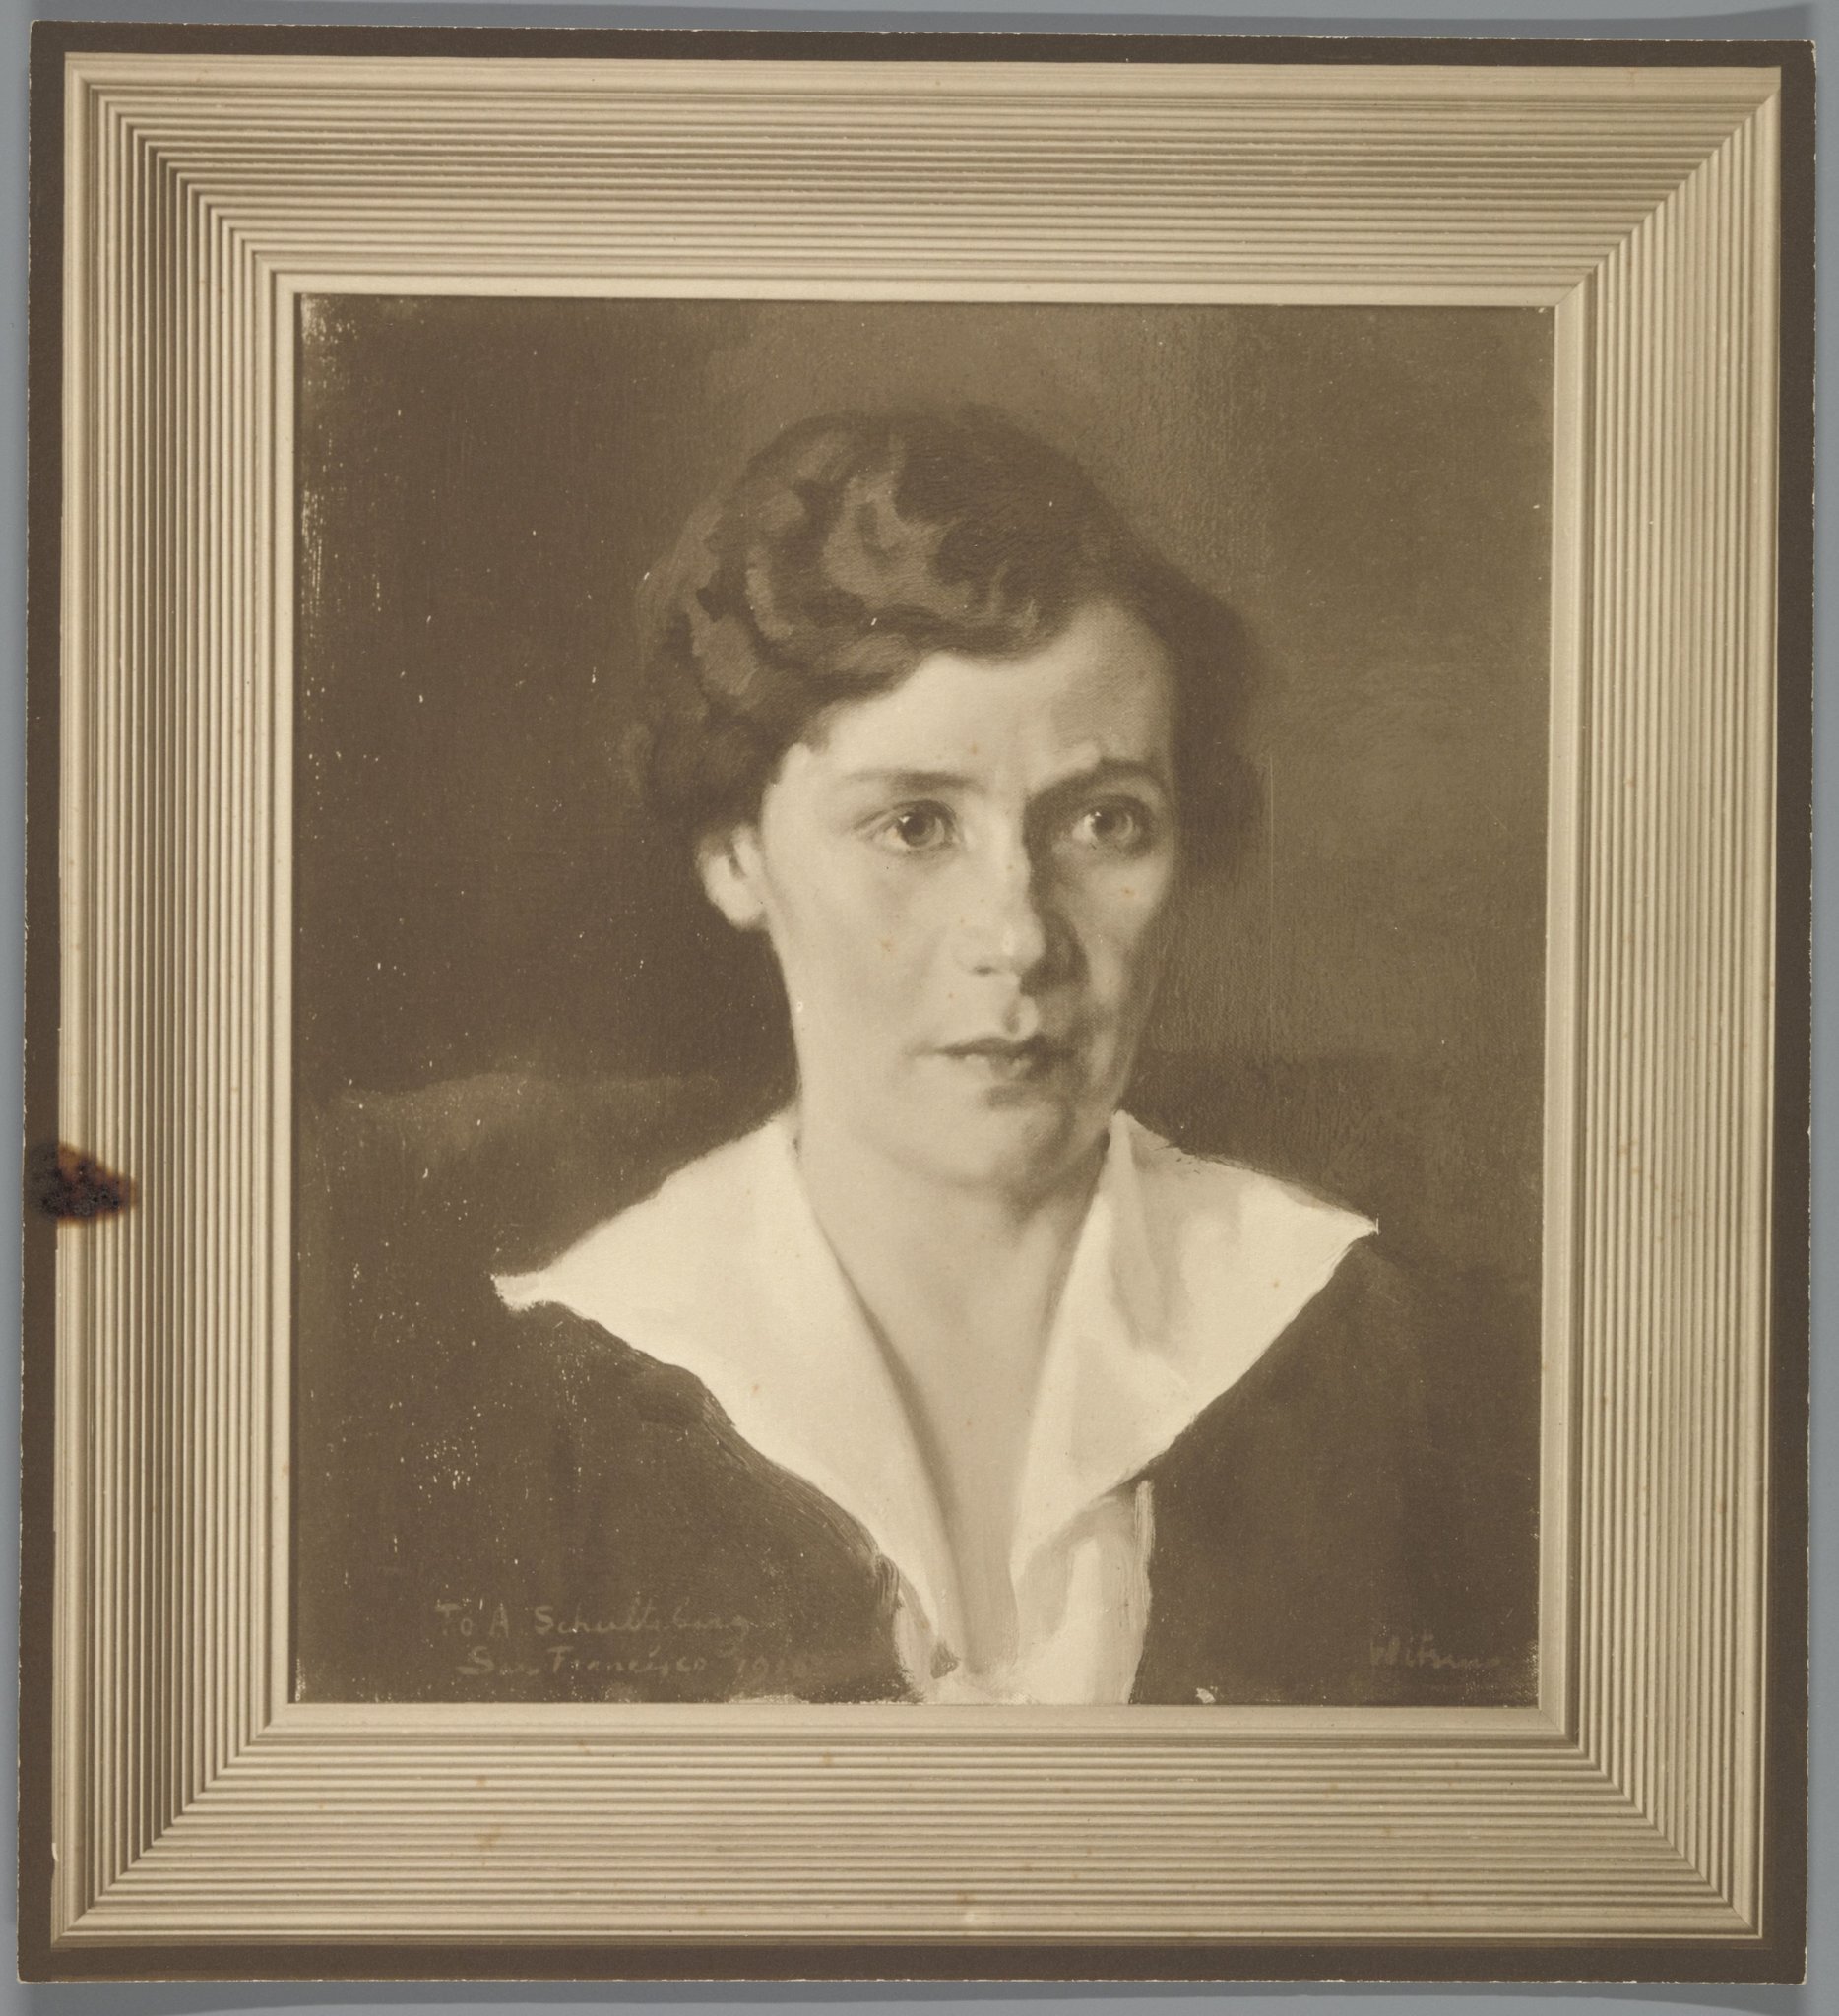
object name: photograph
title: Reproductie naar schilderij van Willem Witsen van een portret van mevrouw A. Schultzberg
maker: Anonymous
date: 1860-1915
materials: paper, photographic support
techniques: gelatin silver print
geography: netherlands